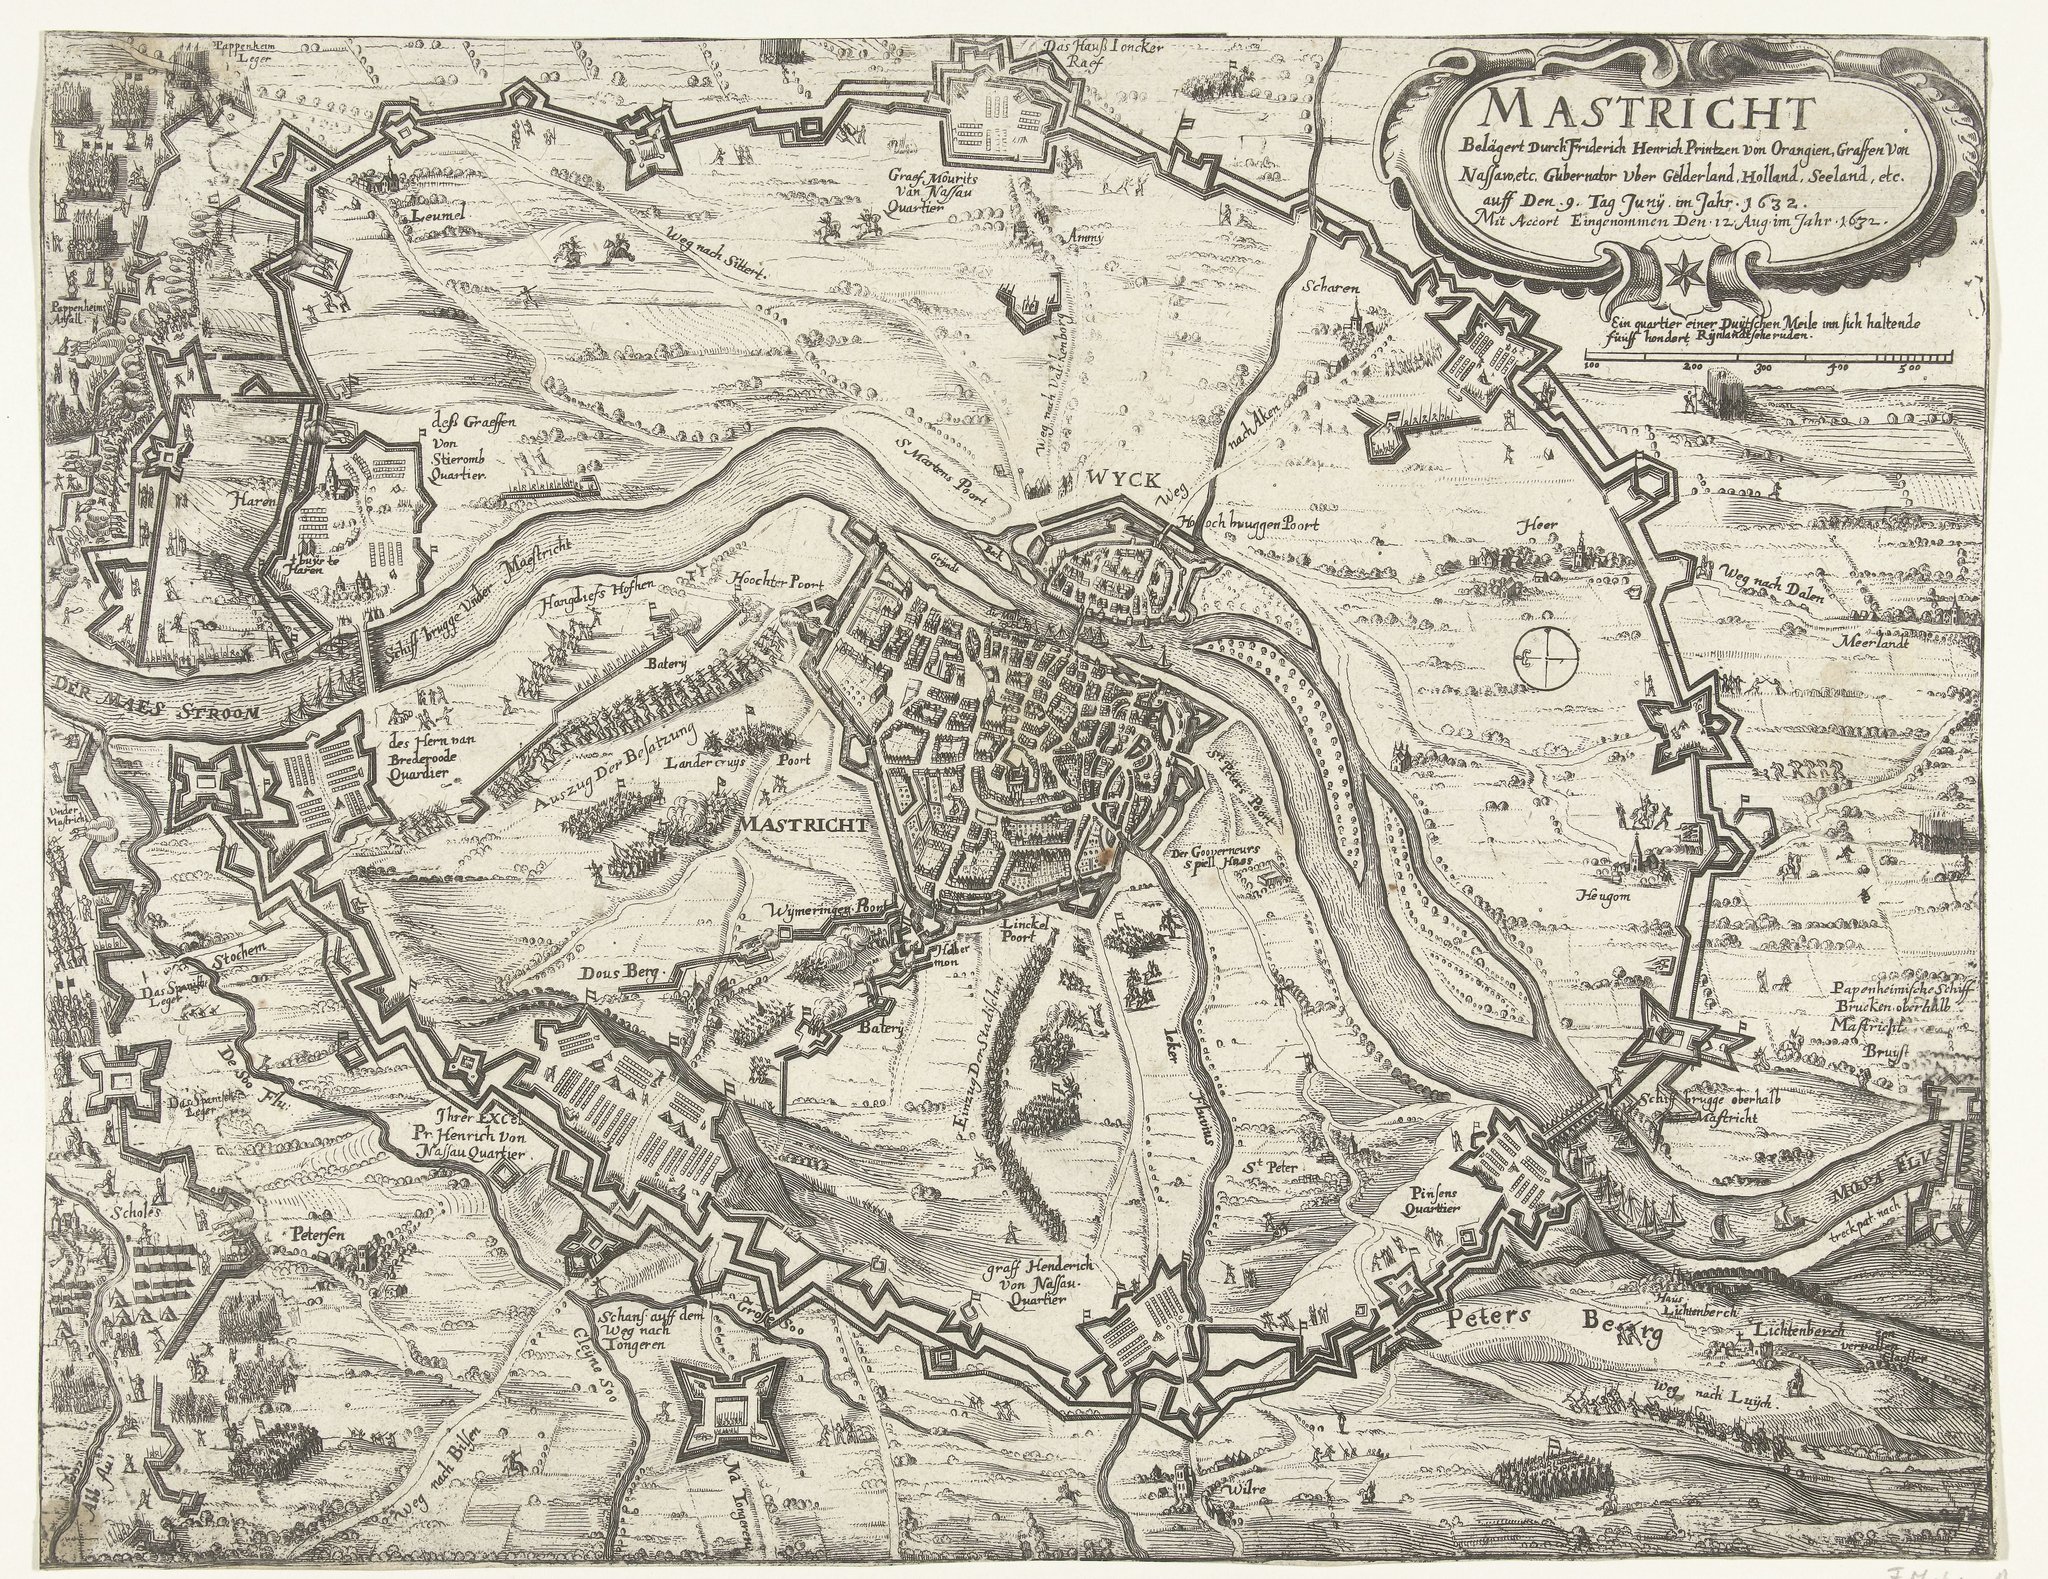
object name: print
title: Maastricht belegerd door Frederik Hendrik, 1632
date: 1632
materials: paper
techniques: etching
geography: germany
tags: delft, frederick henry (prince of orange), maps of separate countries or regions, siege, position war, maps of cities, maastricht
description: Kaart van het beleg van Maastricht door het Staatse leger onder stadhouder Frederik Hendrik, 9 juni tot 21 augustus 1632. Omsingeling van de stad met de verschillende legerkampen van de belegeraars. Aan de linkerkant van de stad de uittocht van de bezetters, onderaan de intocht van het Staatse leger. Met opschriften in de voorstelling in het Duits.